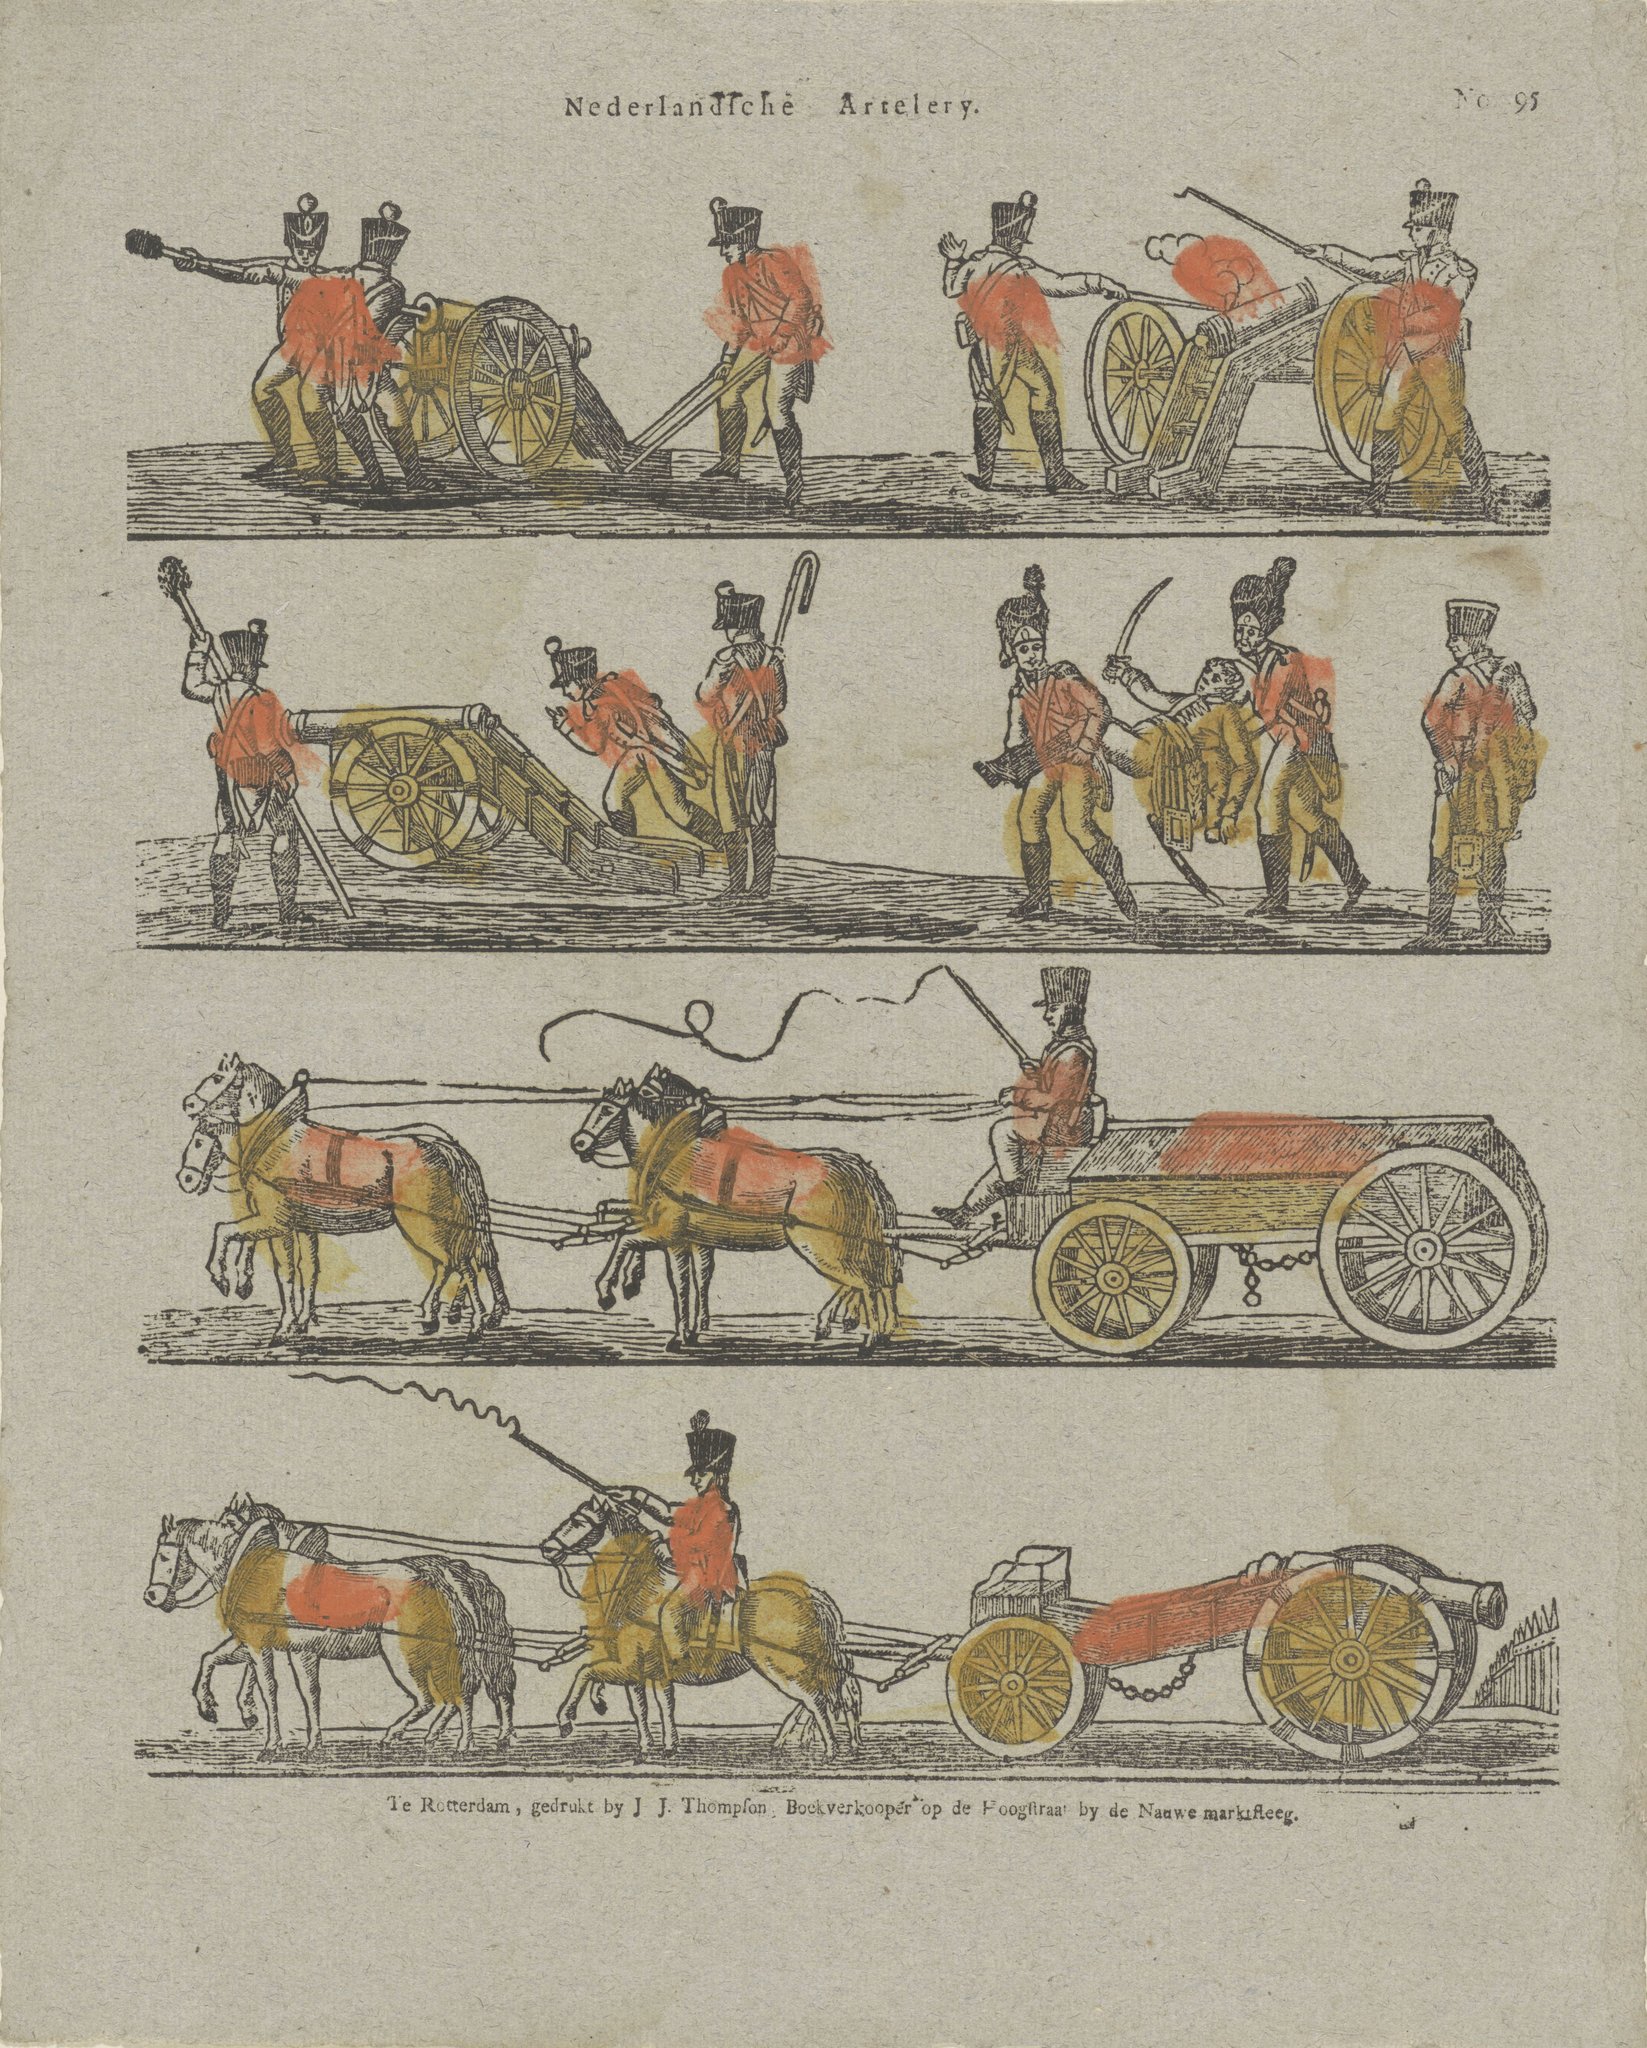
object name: print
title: Nederlandsche artelery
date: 1814-1825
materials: paper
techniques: colour, letterpress printing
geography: netherlands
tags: artillery range, firing range, shooting range ~ military training, the soldier; the soldier's life, (military) equipment and supply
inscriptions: collector's mark: Lugt 2760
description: Blad met 4 horizontale rijen met voorstellingen van de Nederlandse artillerie. Genummerd rechtsboven: No. 95.